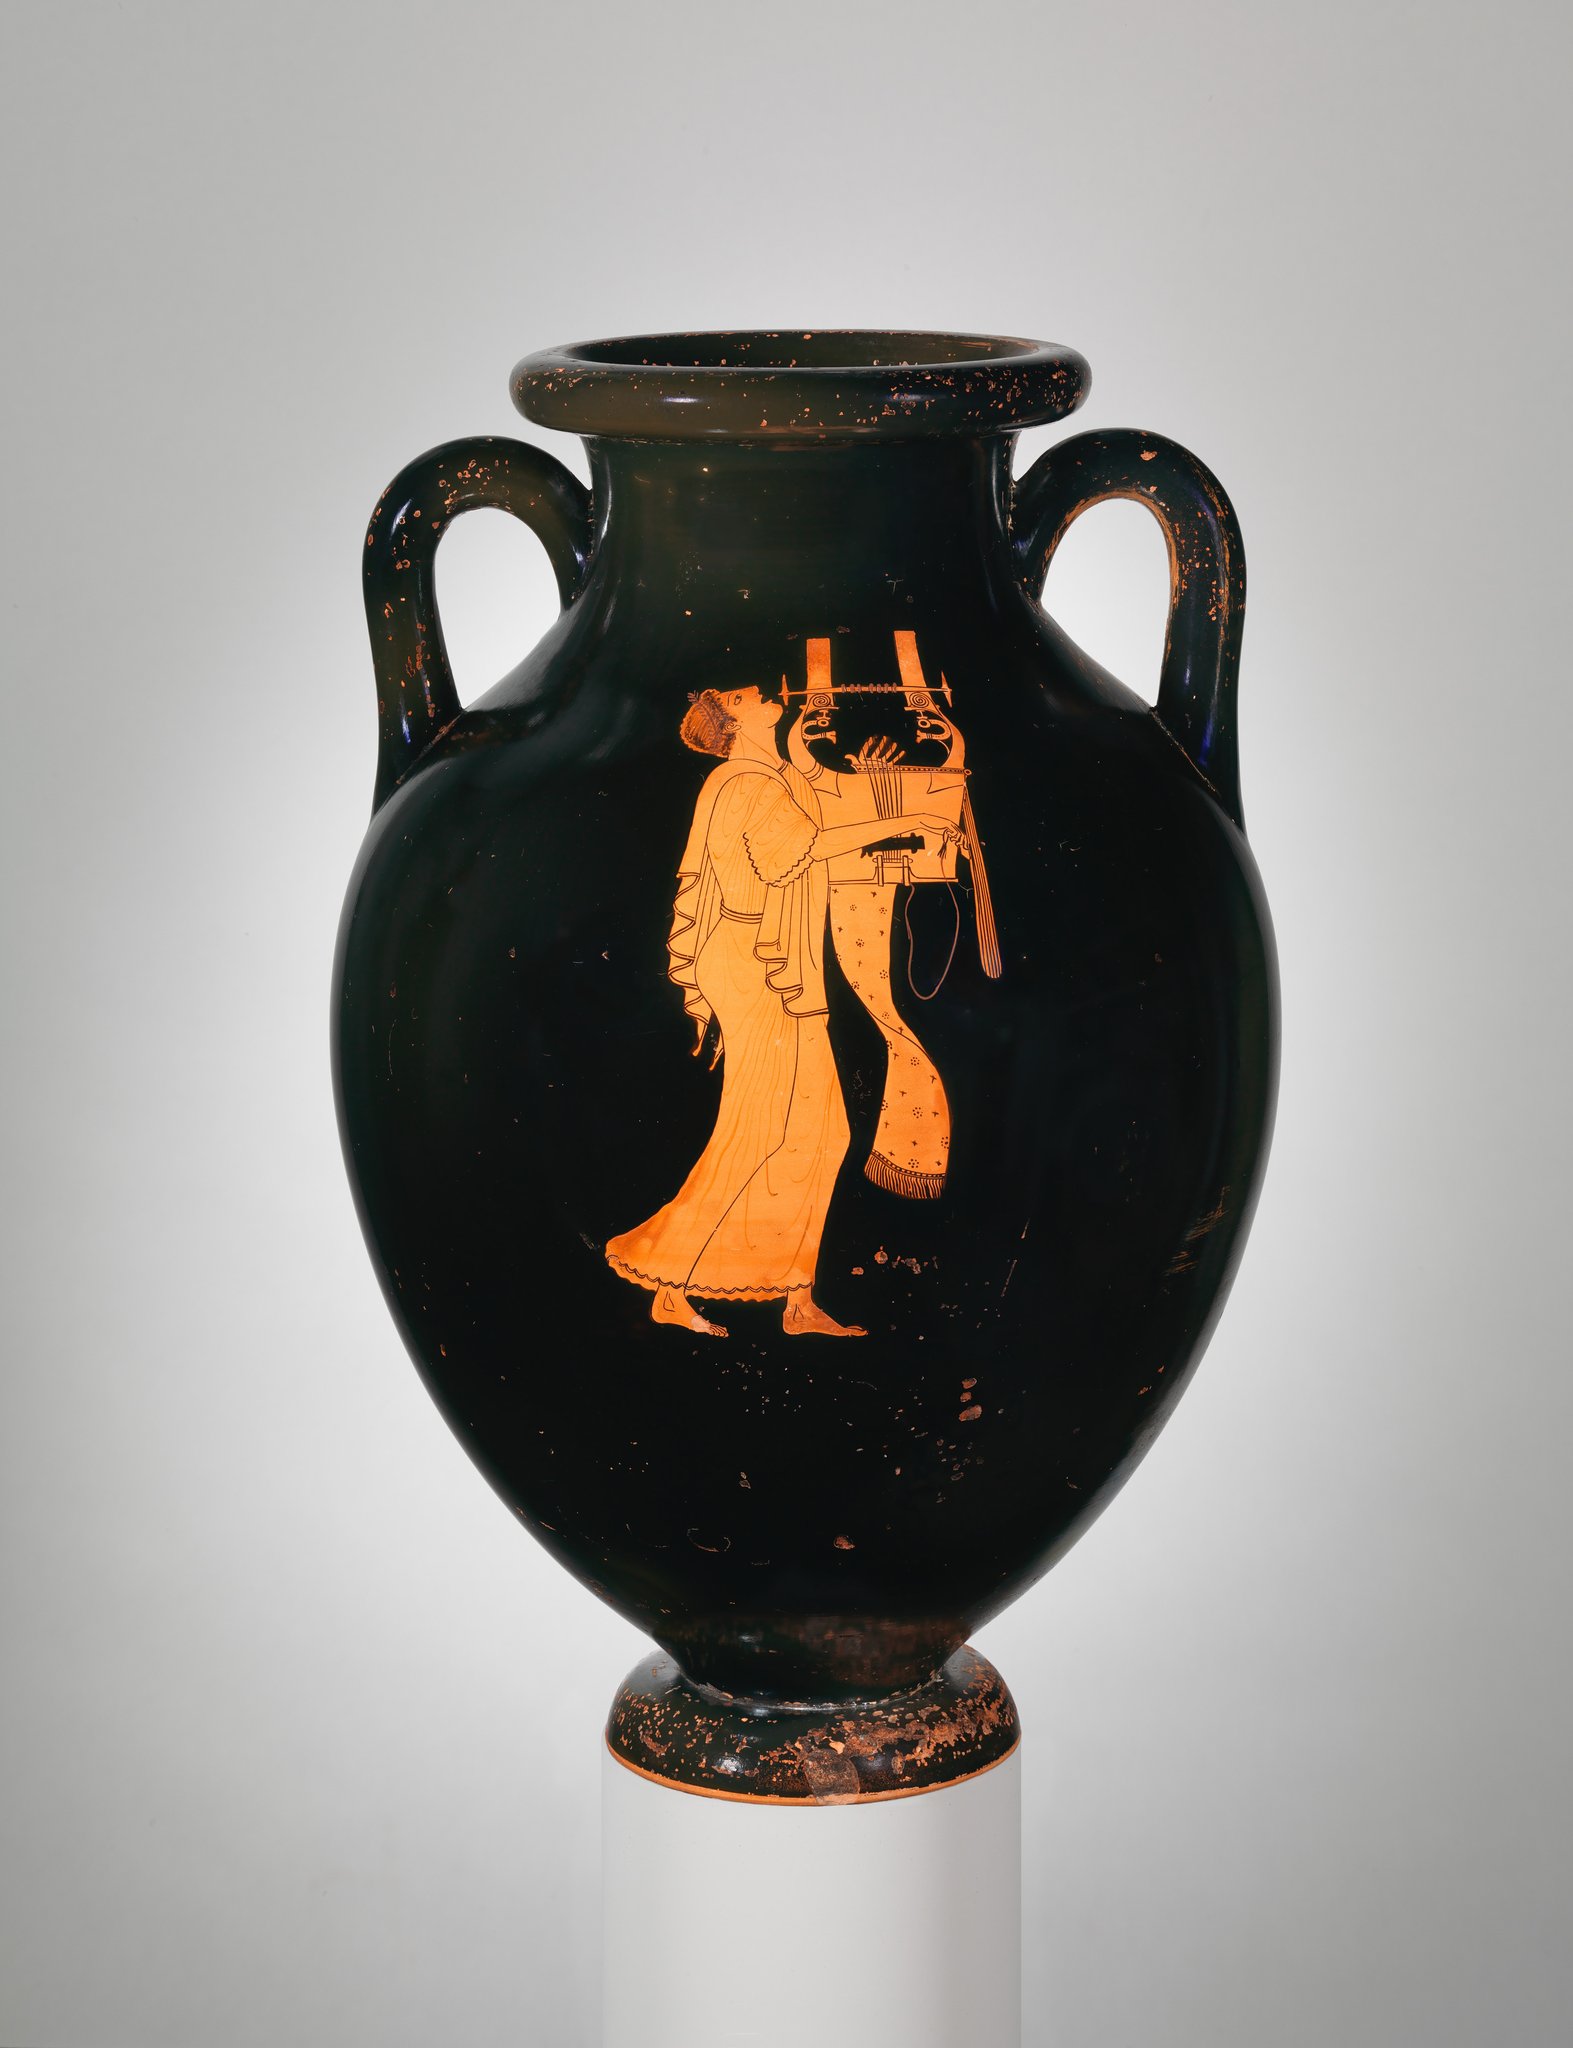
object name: amphora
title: Terracotta amphora (jar)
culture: greek, attic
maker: berlin painter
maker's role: artist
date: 490 BCE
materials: terracotta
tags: musical instruments,men,singing